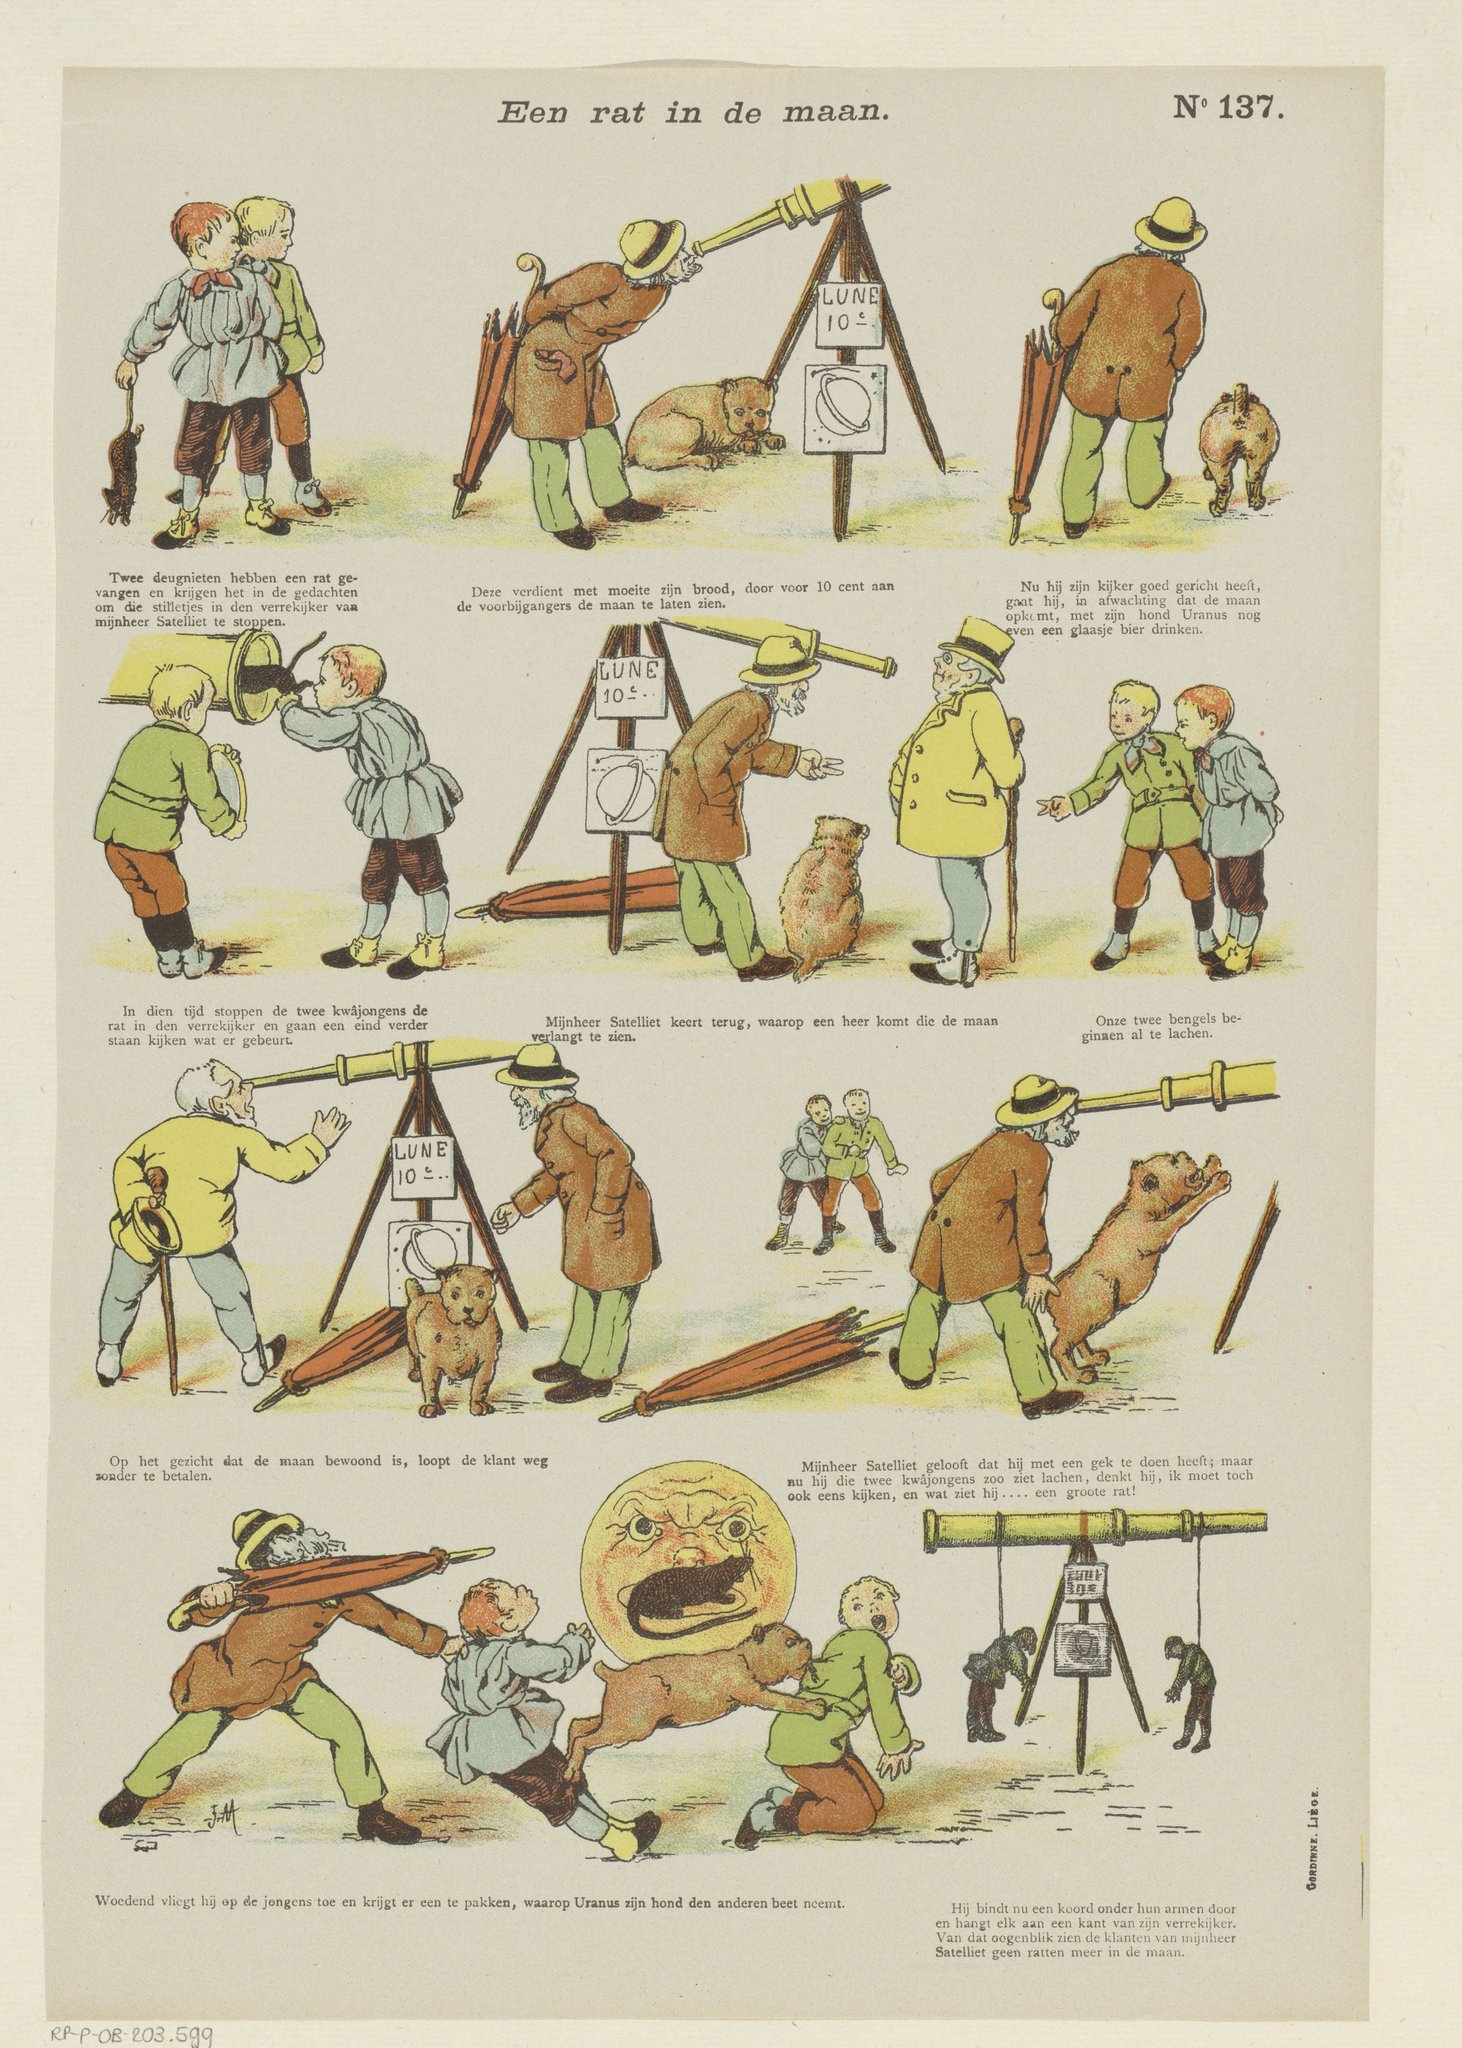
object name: print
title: Een rat in de maan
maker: jules maurel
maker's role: print maker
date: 1894-1959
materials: paper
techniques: lithograph, letterpress printing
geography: liège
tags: mischief-making play, full moon represented as face, rodents: rat, telescope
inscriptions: collector's mark: Lugt 2760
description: Blad met 9 voorstellingen over twee kwajongens die een rat in een telescoop stoppen. Een man die erdoor naar de maan kijkt denkt dat er leven is op de maan. Onder elke afbeelding een onderschrift. Genummerd rechtsboven: No 137.